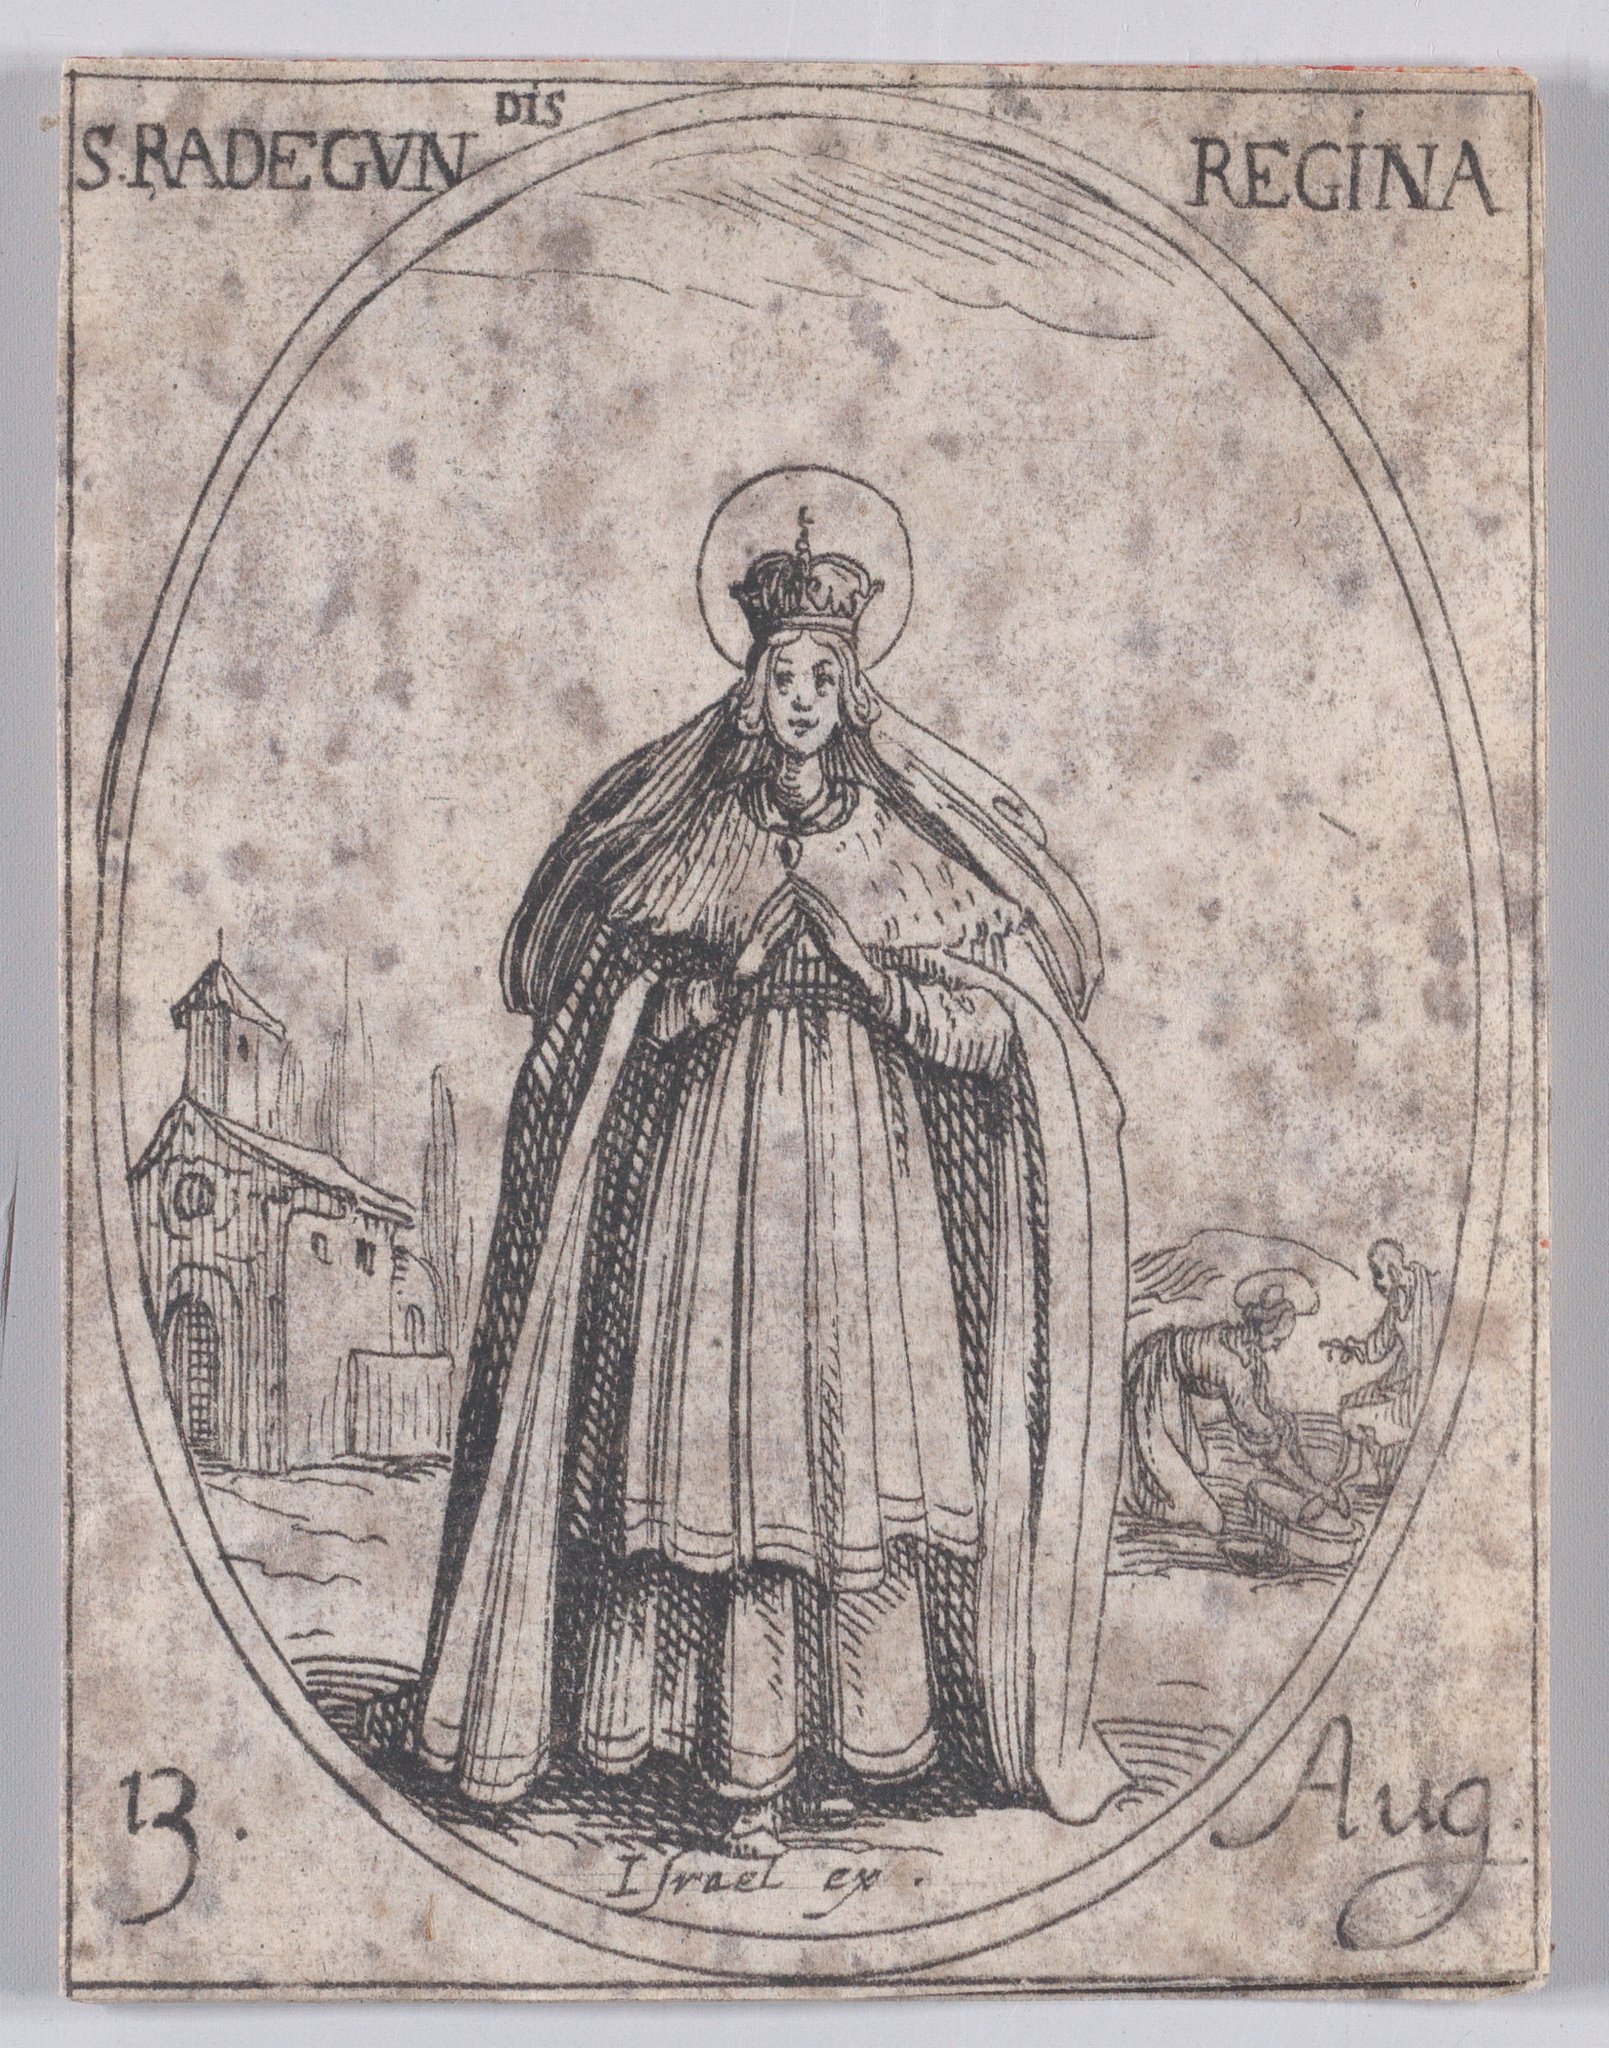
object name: print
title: Ste. Radegonde, reine (St. Radagund, Queen), August 13th, from "Les Images De Tous Les Saincts et Saintes de L'Année" (Images of All of the Saints and Religious Events of the Year)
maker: jacques callot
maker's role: artist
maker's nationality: french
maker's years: 1592-1635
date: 1636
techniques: etching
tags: queens,women,saints